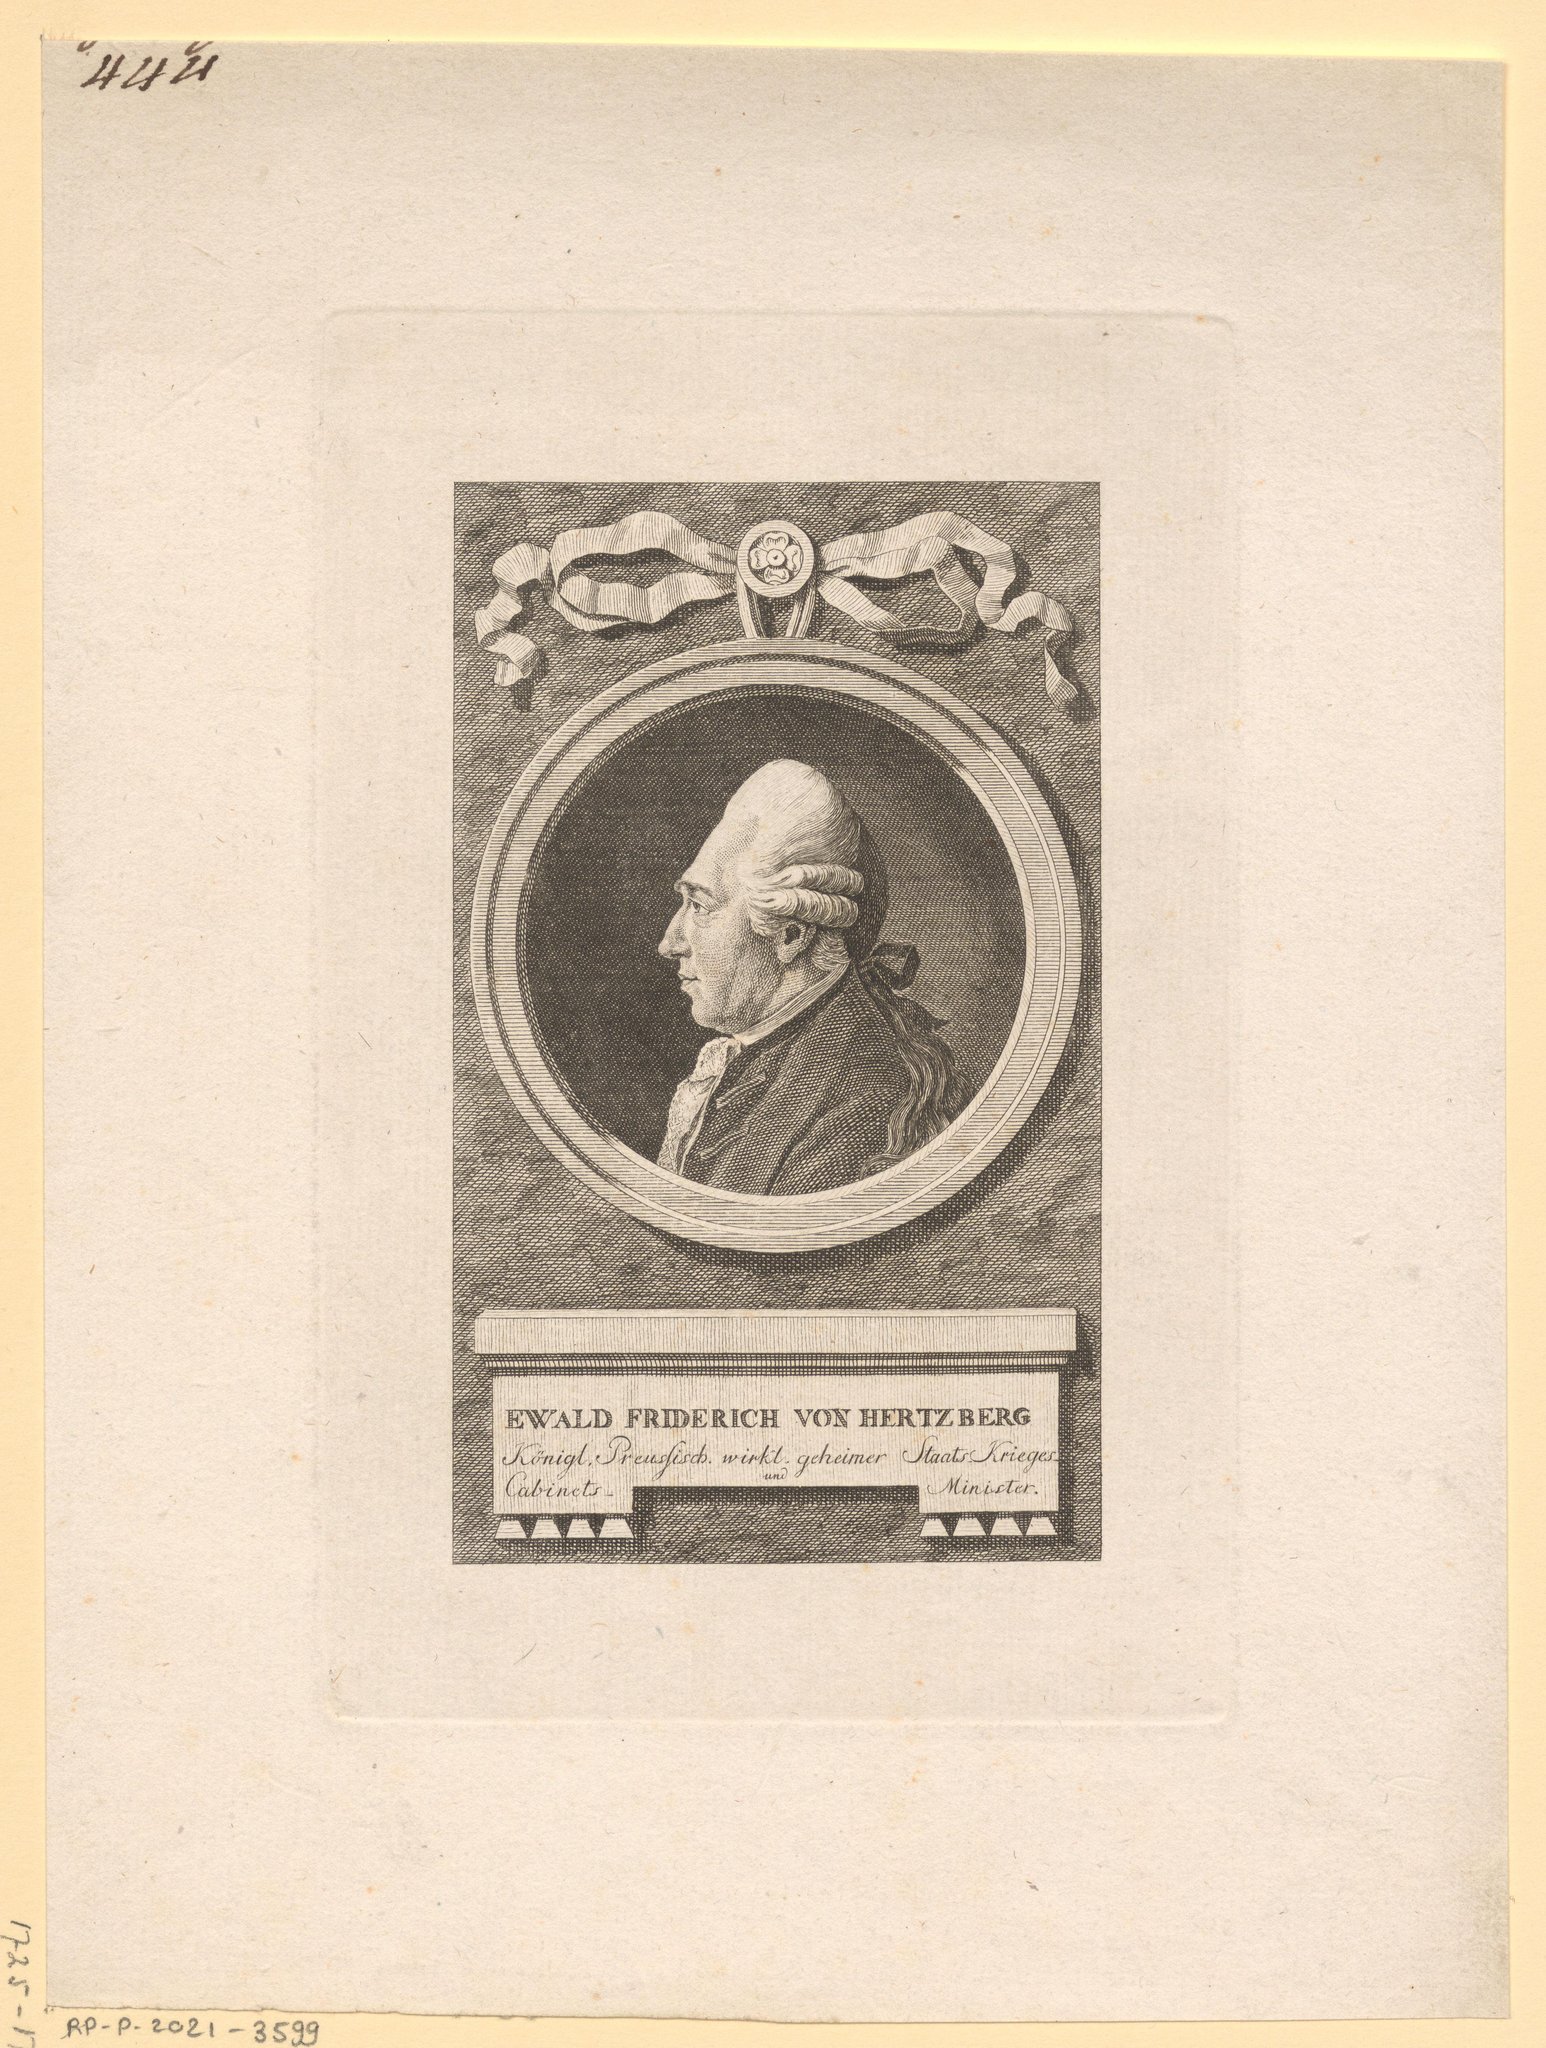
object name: print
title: Portret van Ewald Friedrich von Hertzberg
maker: Anonymous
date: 1763-1799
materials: paper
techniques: engraving, etching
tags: poland, berlin, ewald friedrich von hertzberg (graaf), historical persons, politician, e.g. party leader